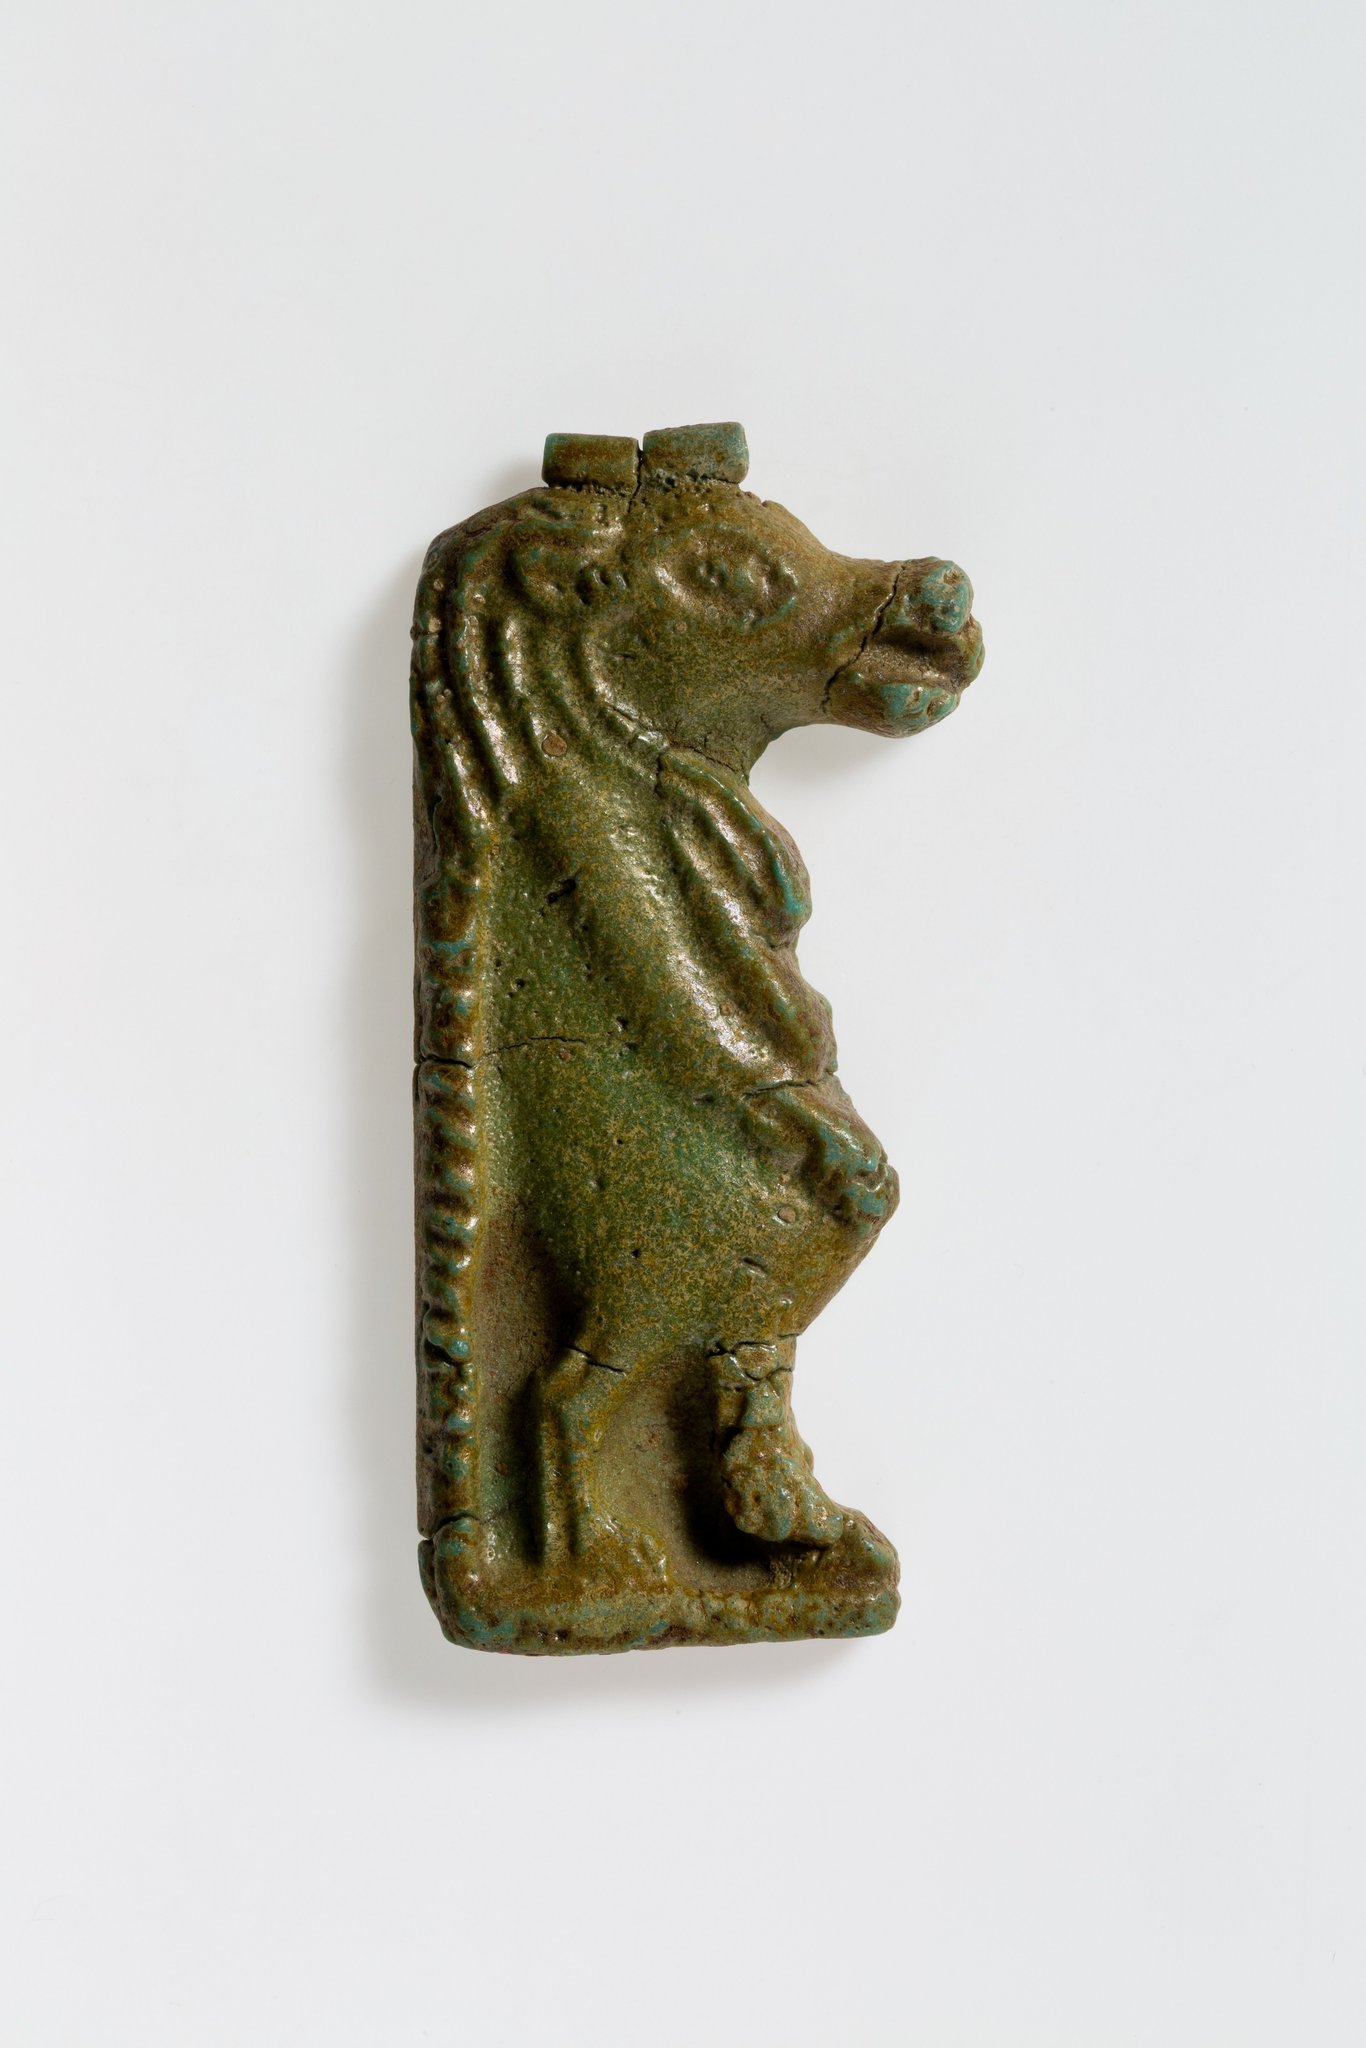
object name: amulet, taweret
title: Taweret Amulet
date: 664-630 BCE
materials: faience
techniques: glazing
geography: egypt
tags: taweret